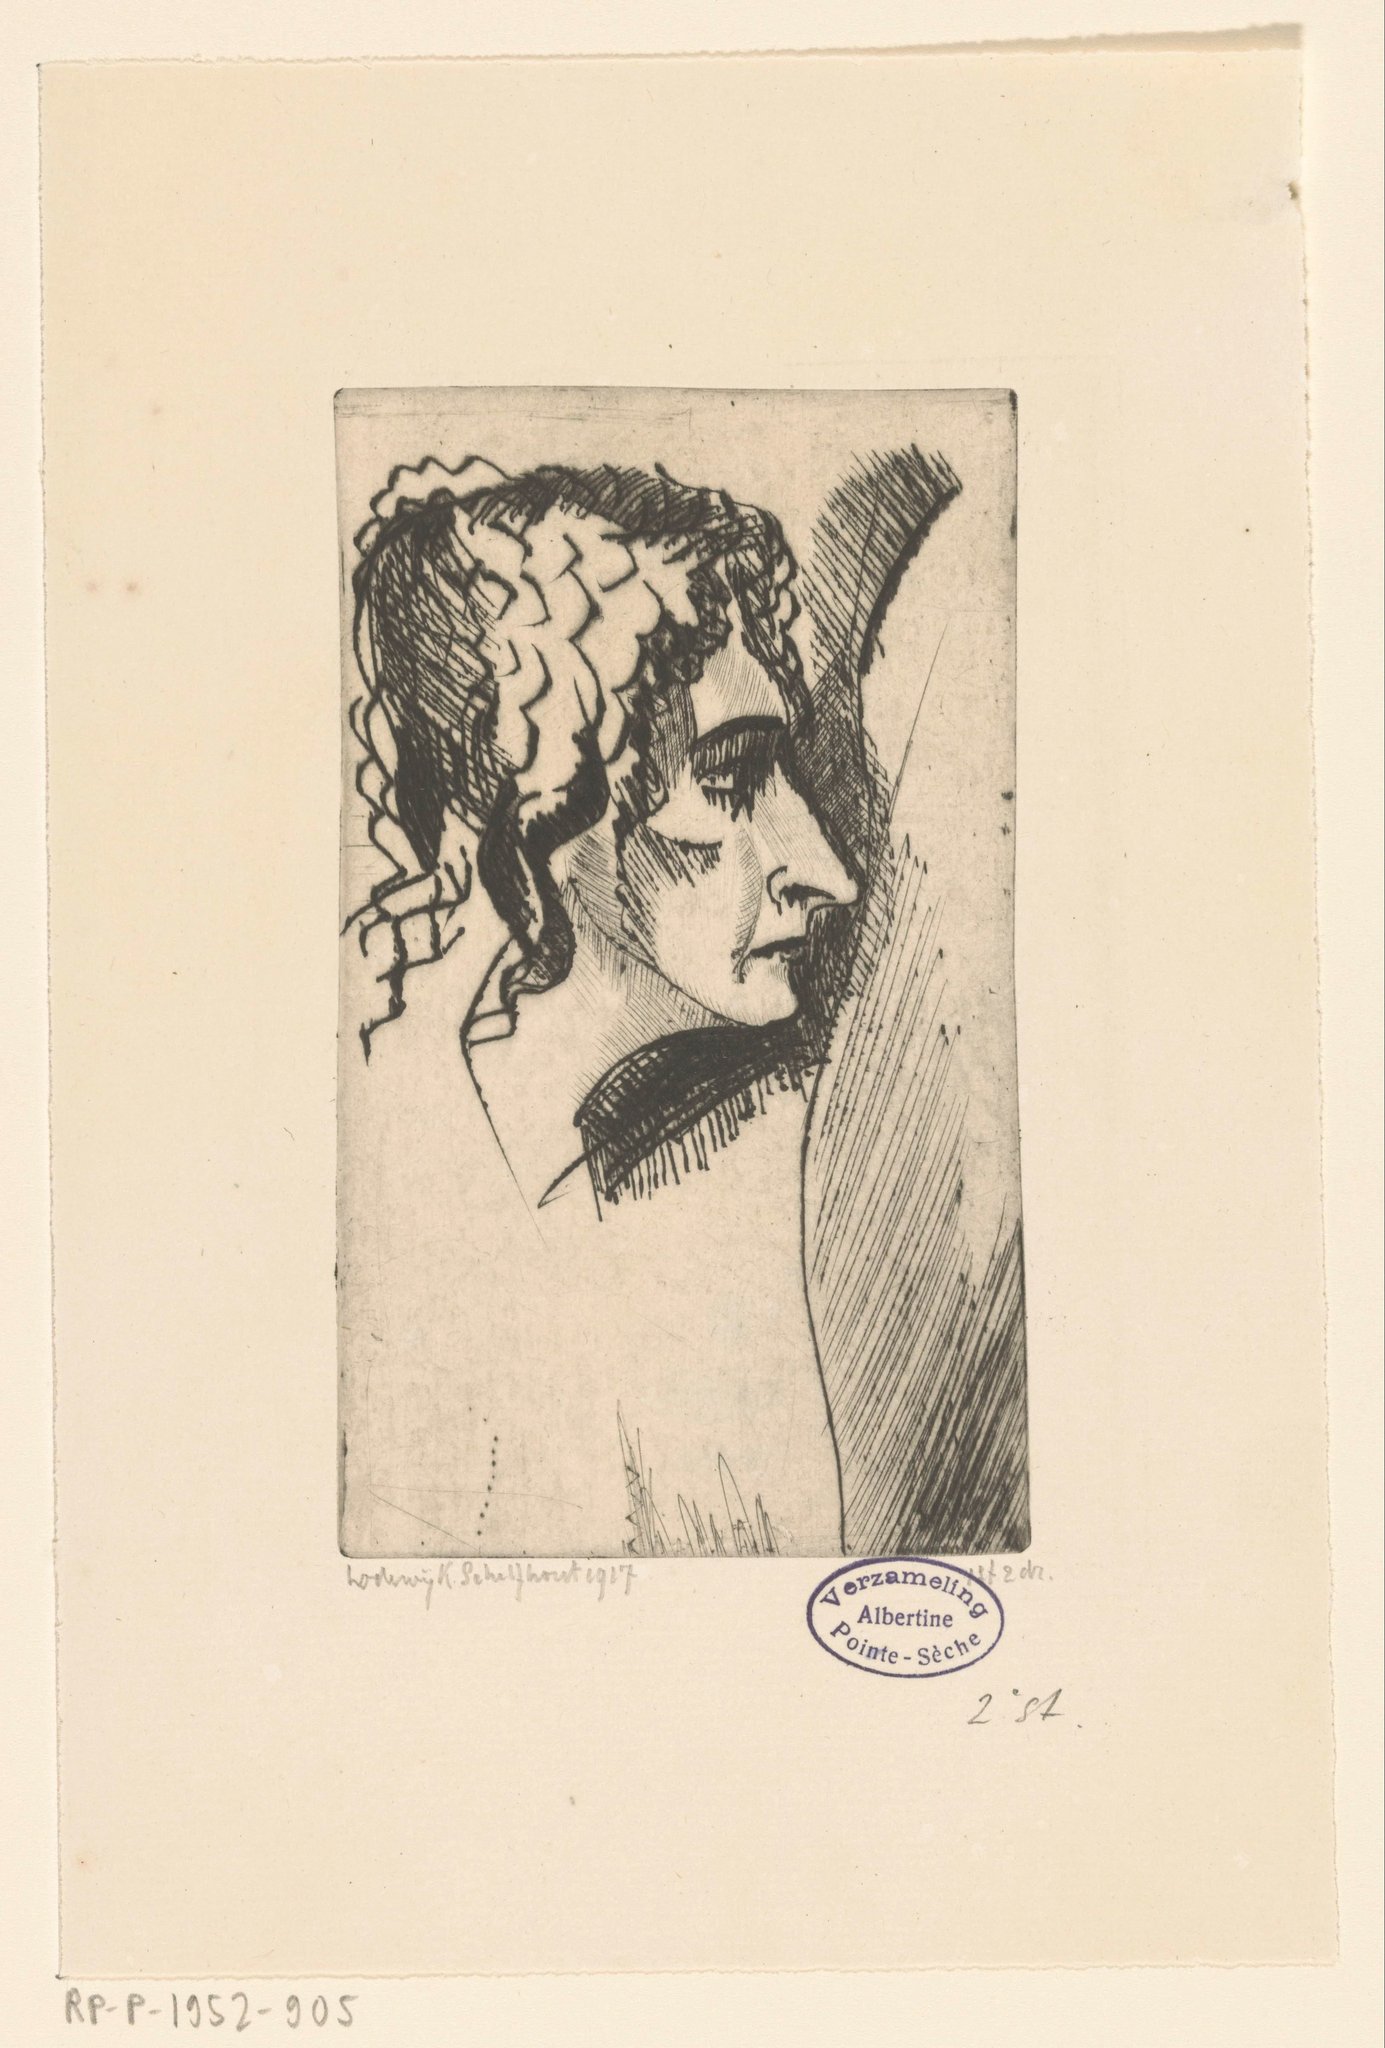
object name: print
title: Hoofd van een vrouw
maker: lodewijk schelfhout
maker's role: draughtsman, print maker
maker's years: 1881-1943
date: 1917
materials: paper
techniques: drypoint, intaglio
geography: netherlands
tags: head (human) - aa - female human figure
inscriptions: collector's mark: Lugt 5i, collector's mark: Lugt 2228, collector's mark: Lugt 2760